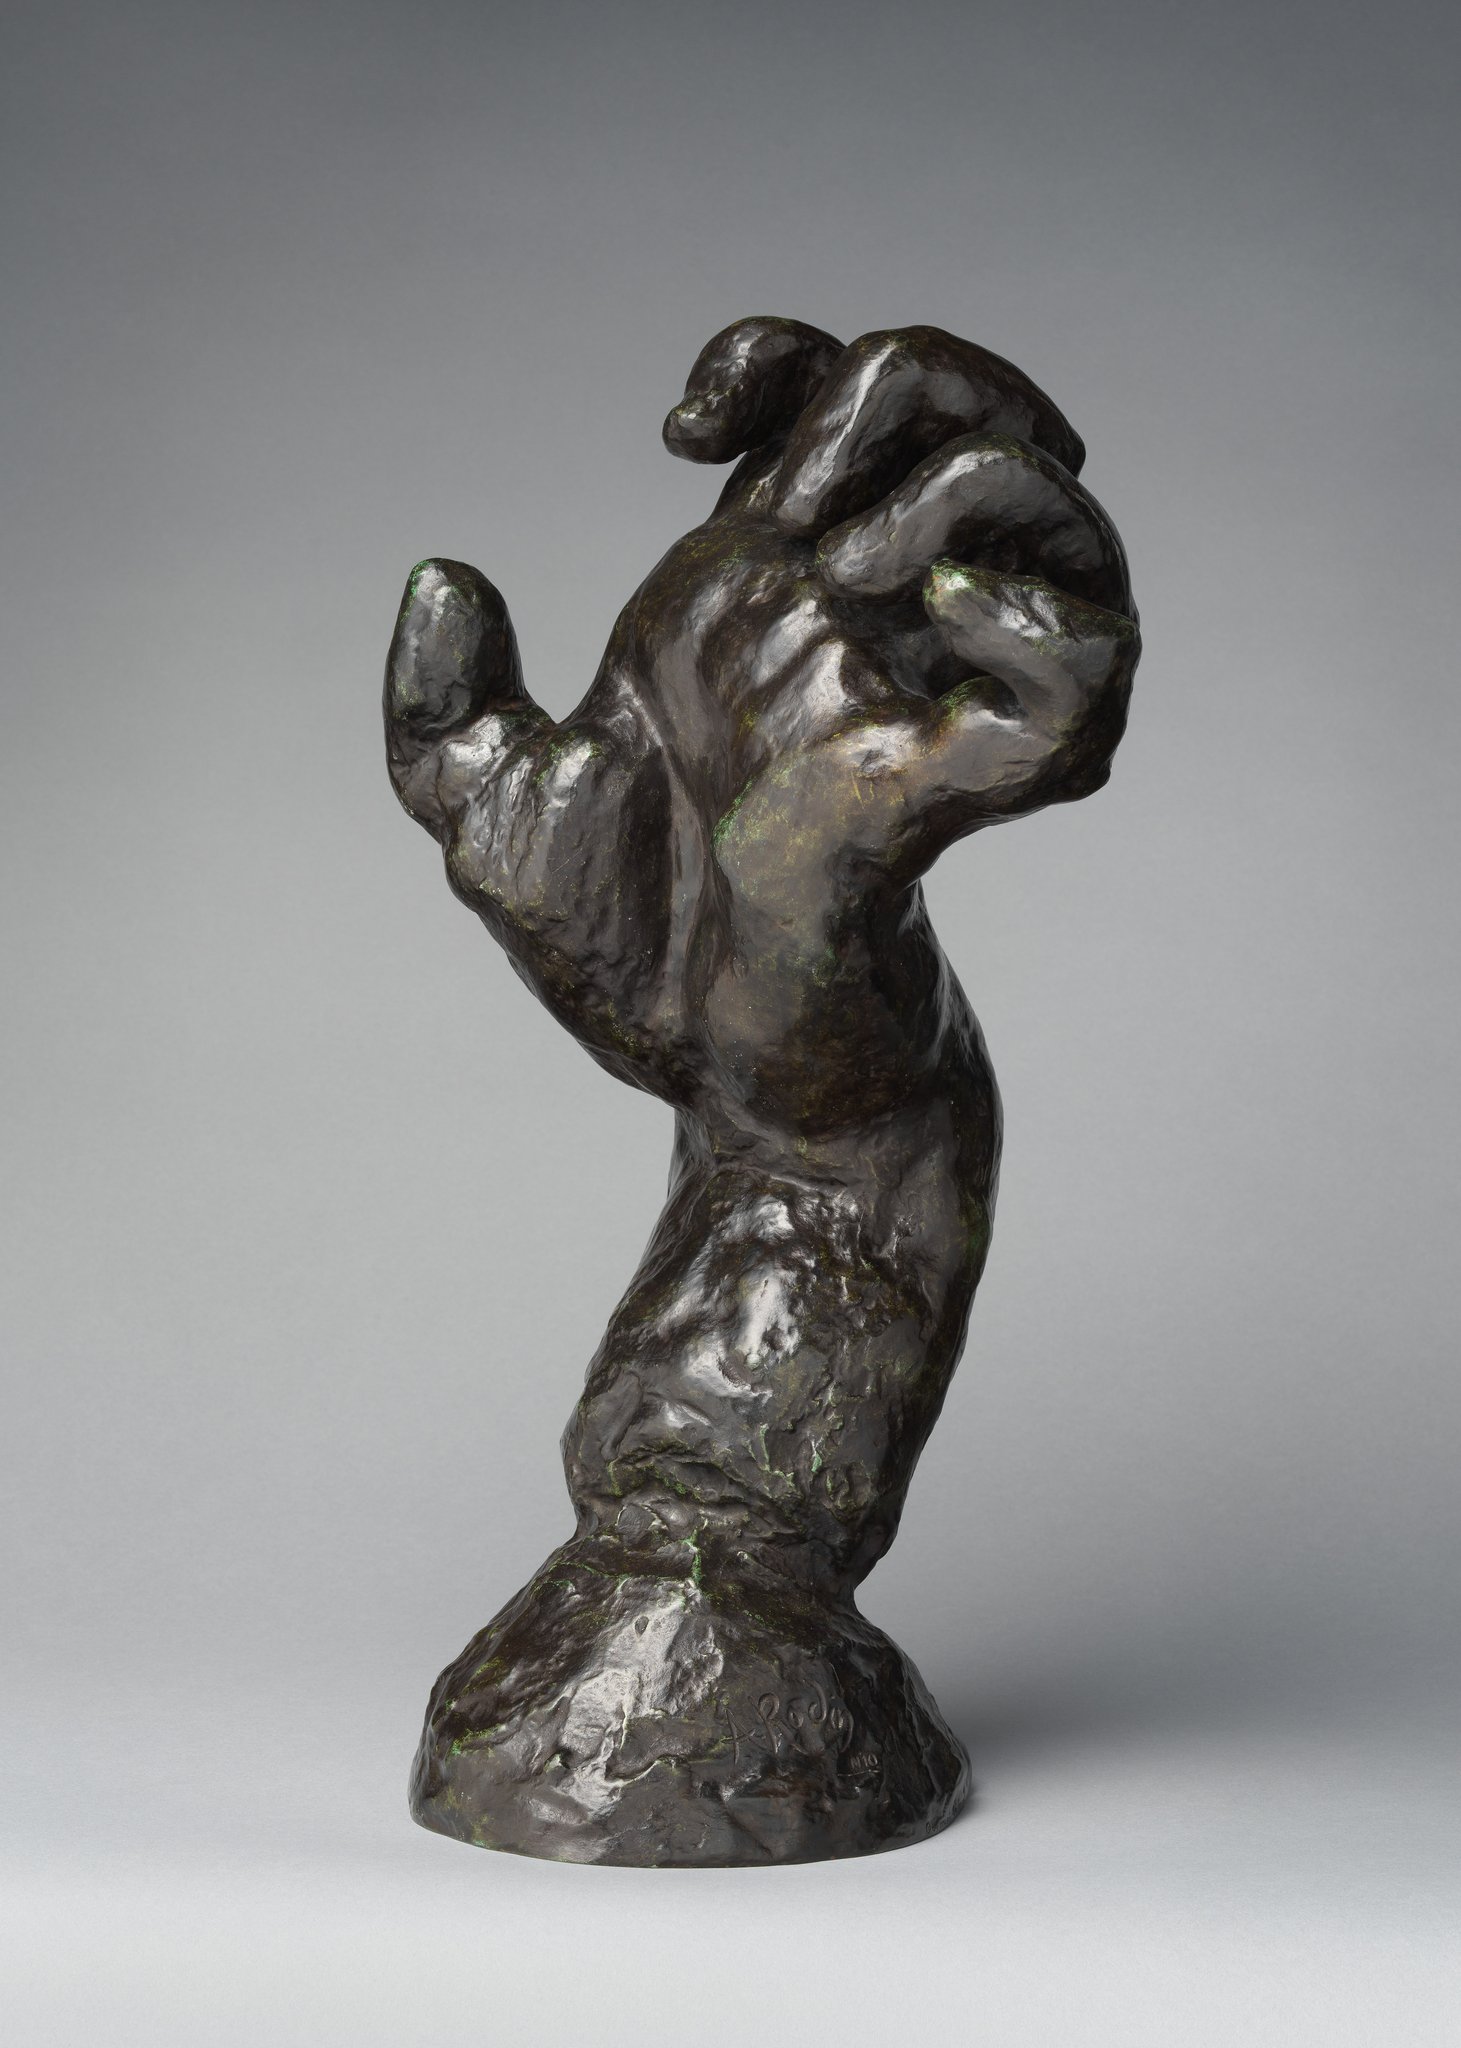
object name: sculpture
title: The Clenched Left Hand (Study for Hand of Pierre de Wiessant)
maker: auguste rodin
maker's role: artist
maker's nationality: french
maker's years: 1840-1917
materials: bronze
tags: hands